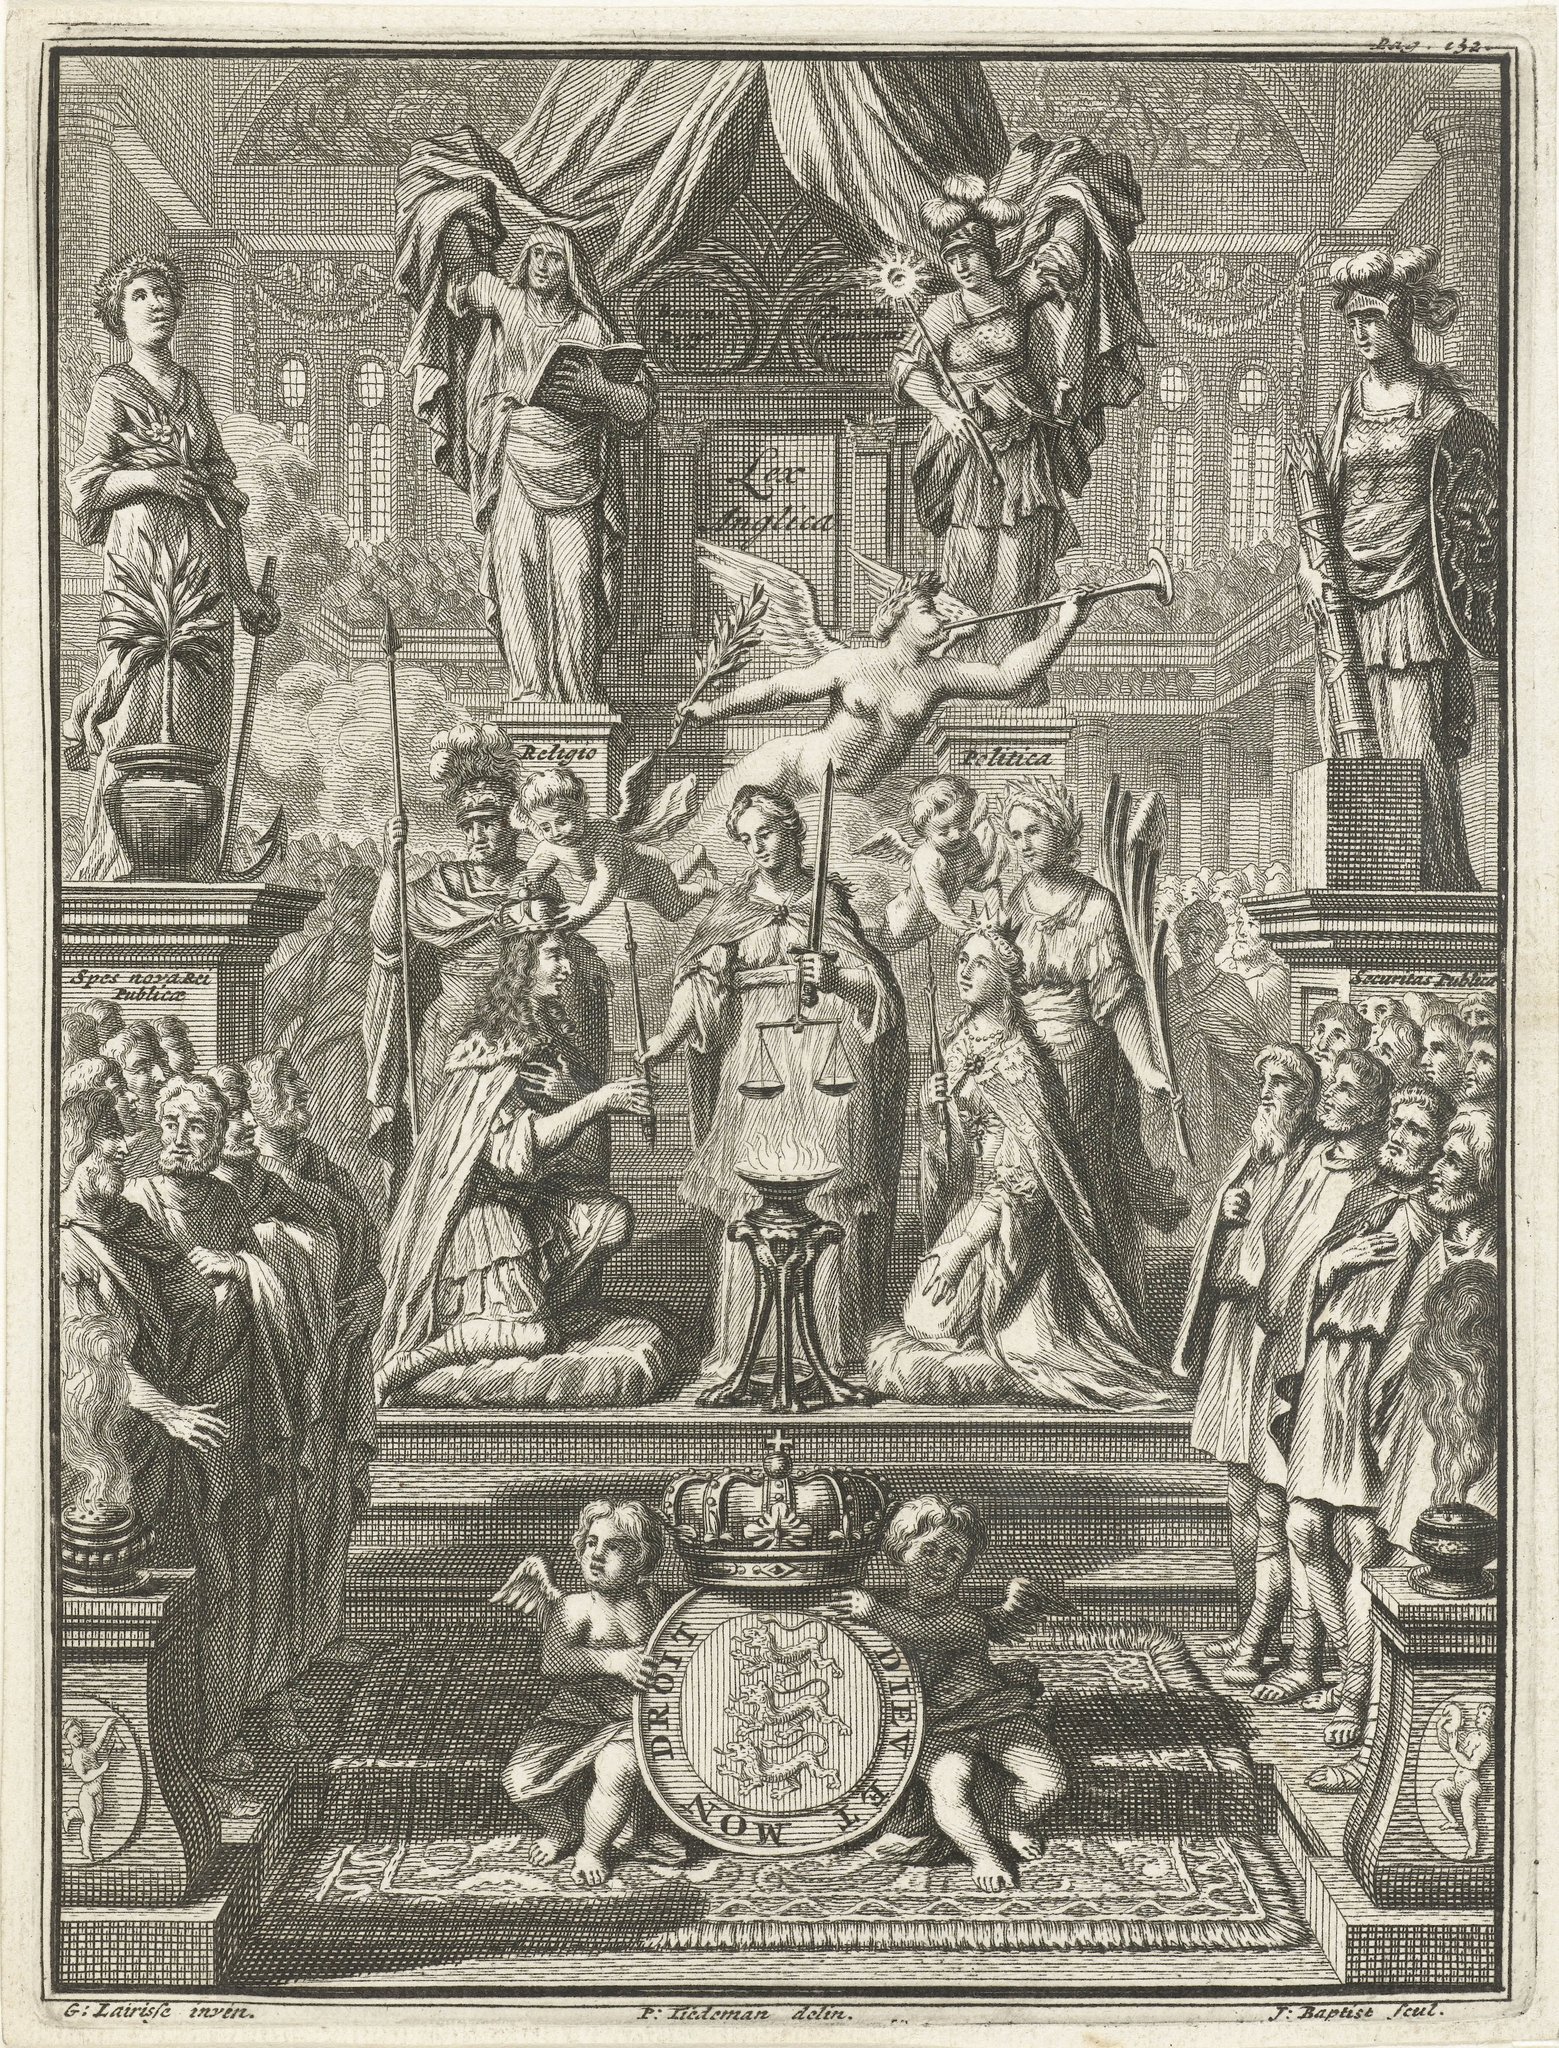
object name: print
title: Kroning van Willem III en Maria Stuart, 1689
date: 1696-1700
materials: paper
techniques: engraving, etching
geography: amsterdam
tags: the hague, william iii (prince of orange and king of england, scotland, and ireland), london, maria ii stuart (koningin van engeland, schotland en ierland)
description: Allegorie op de kroning van koning Willem III en koningin Maria II Stuart, 21 april 1689. Willem III en Maria Stuart knielen aan weerszijden van Rechtvaardigheid. Twee putti zetten kronen op hun hoofden. Een engel blaast op een bazuin. Rechtvaardigheid overhandigt het paar scepters. Het volk is in grote getalen aanwezig.